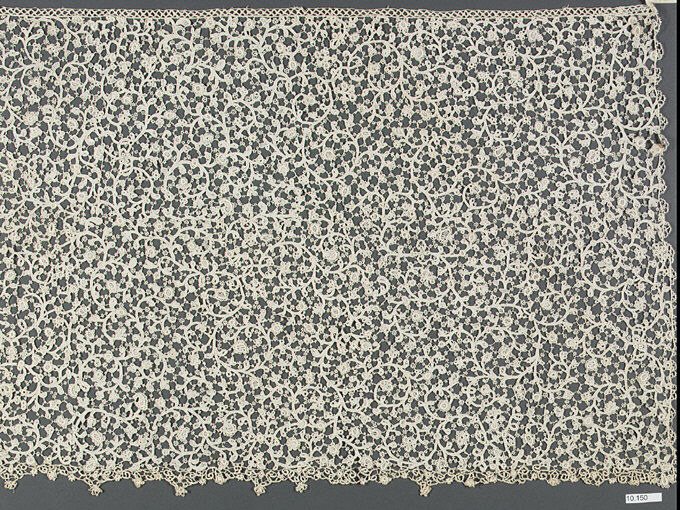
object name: flounce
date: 1667-1700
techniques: lace